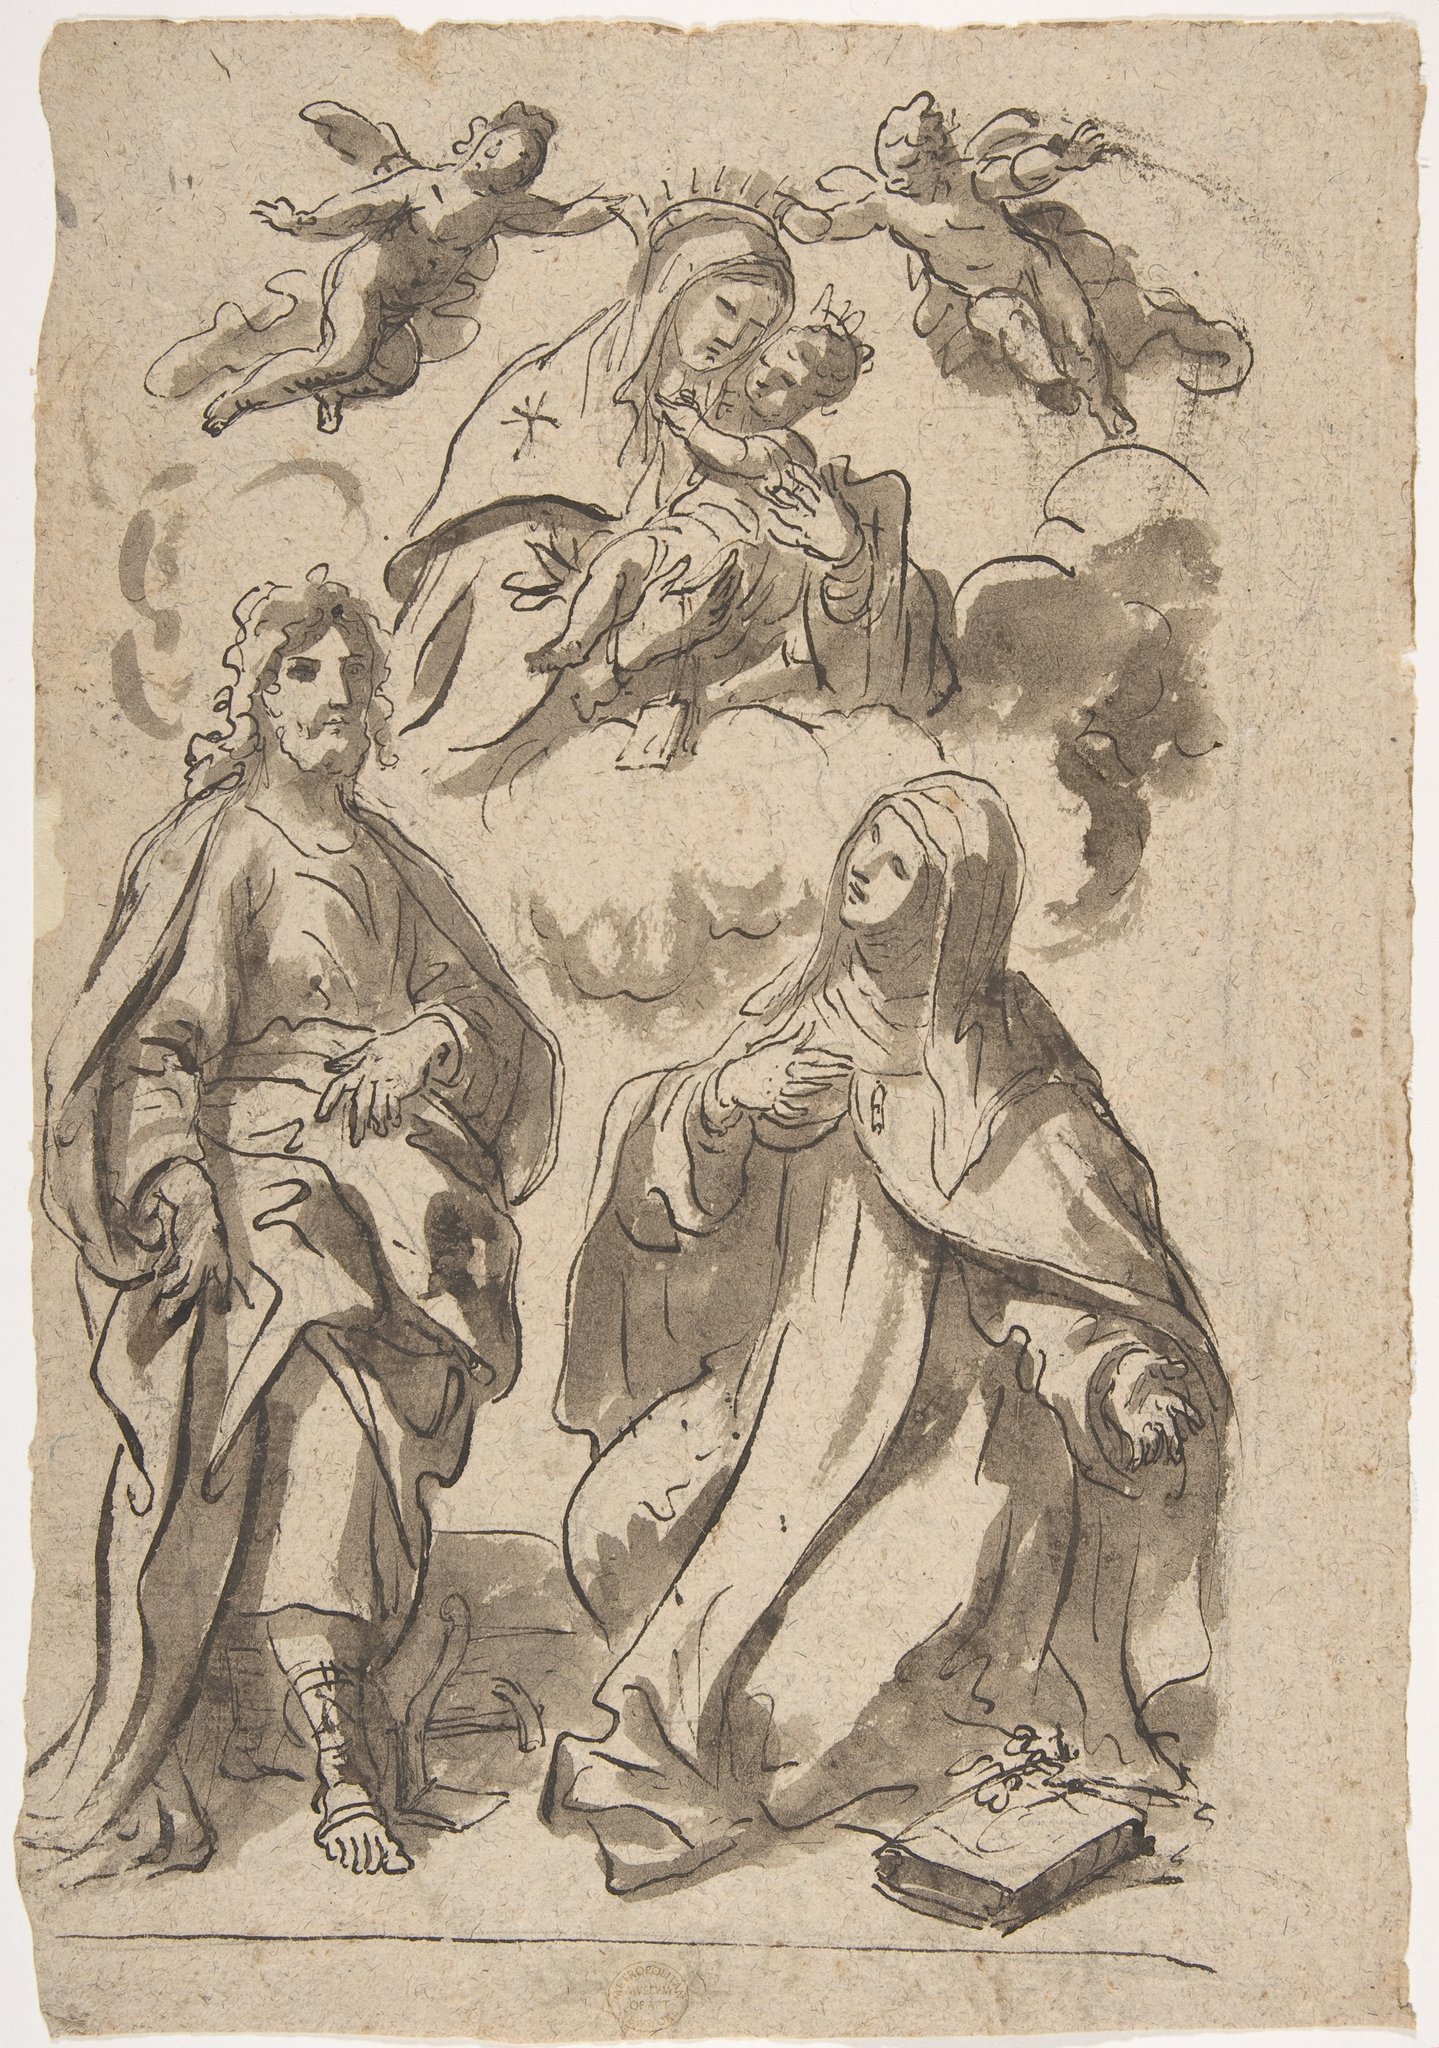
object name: drawing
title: A Male and a Female Saint (Joseph of Aramathea? and Saint Catherine of Siena? Adoring the Virgin and Child in Glory (recto); Minerva Bellona with a Victorious Warrior (verso)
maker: francesco di maria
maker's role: artist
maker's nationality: italian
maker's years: 1623-1690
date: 1623-1690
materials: chalk, ink, paper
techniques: brush, highlighting, pen, wash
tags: angels,madonna and child,saint catherine